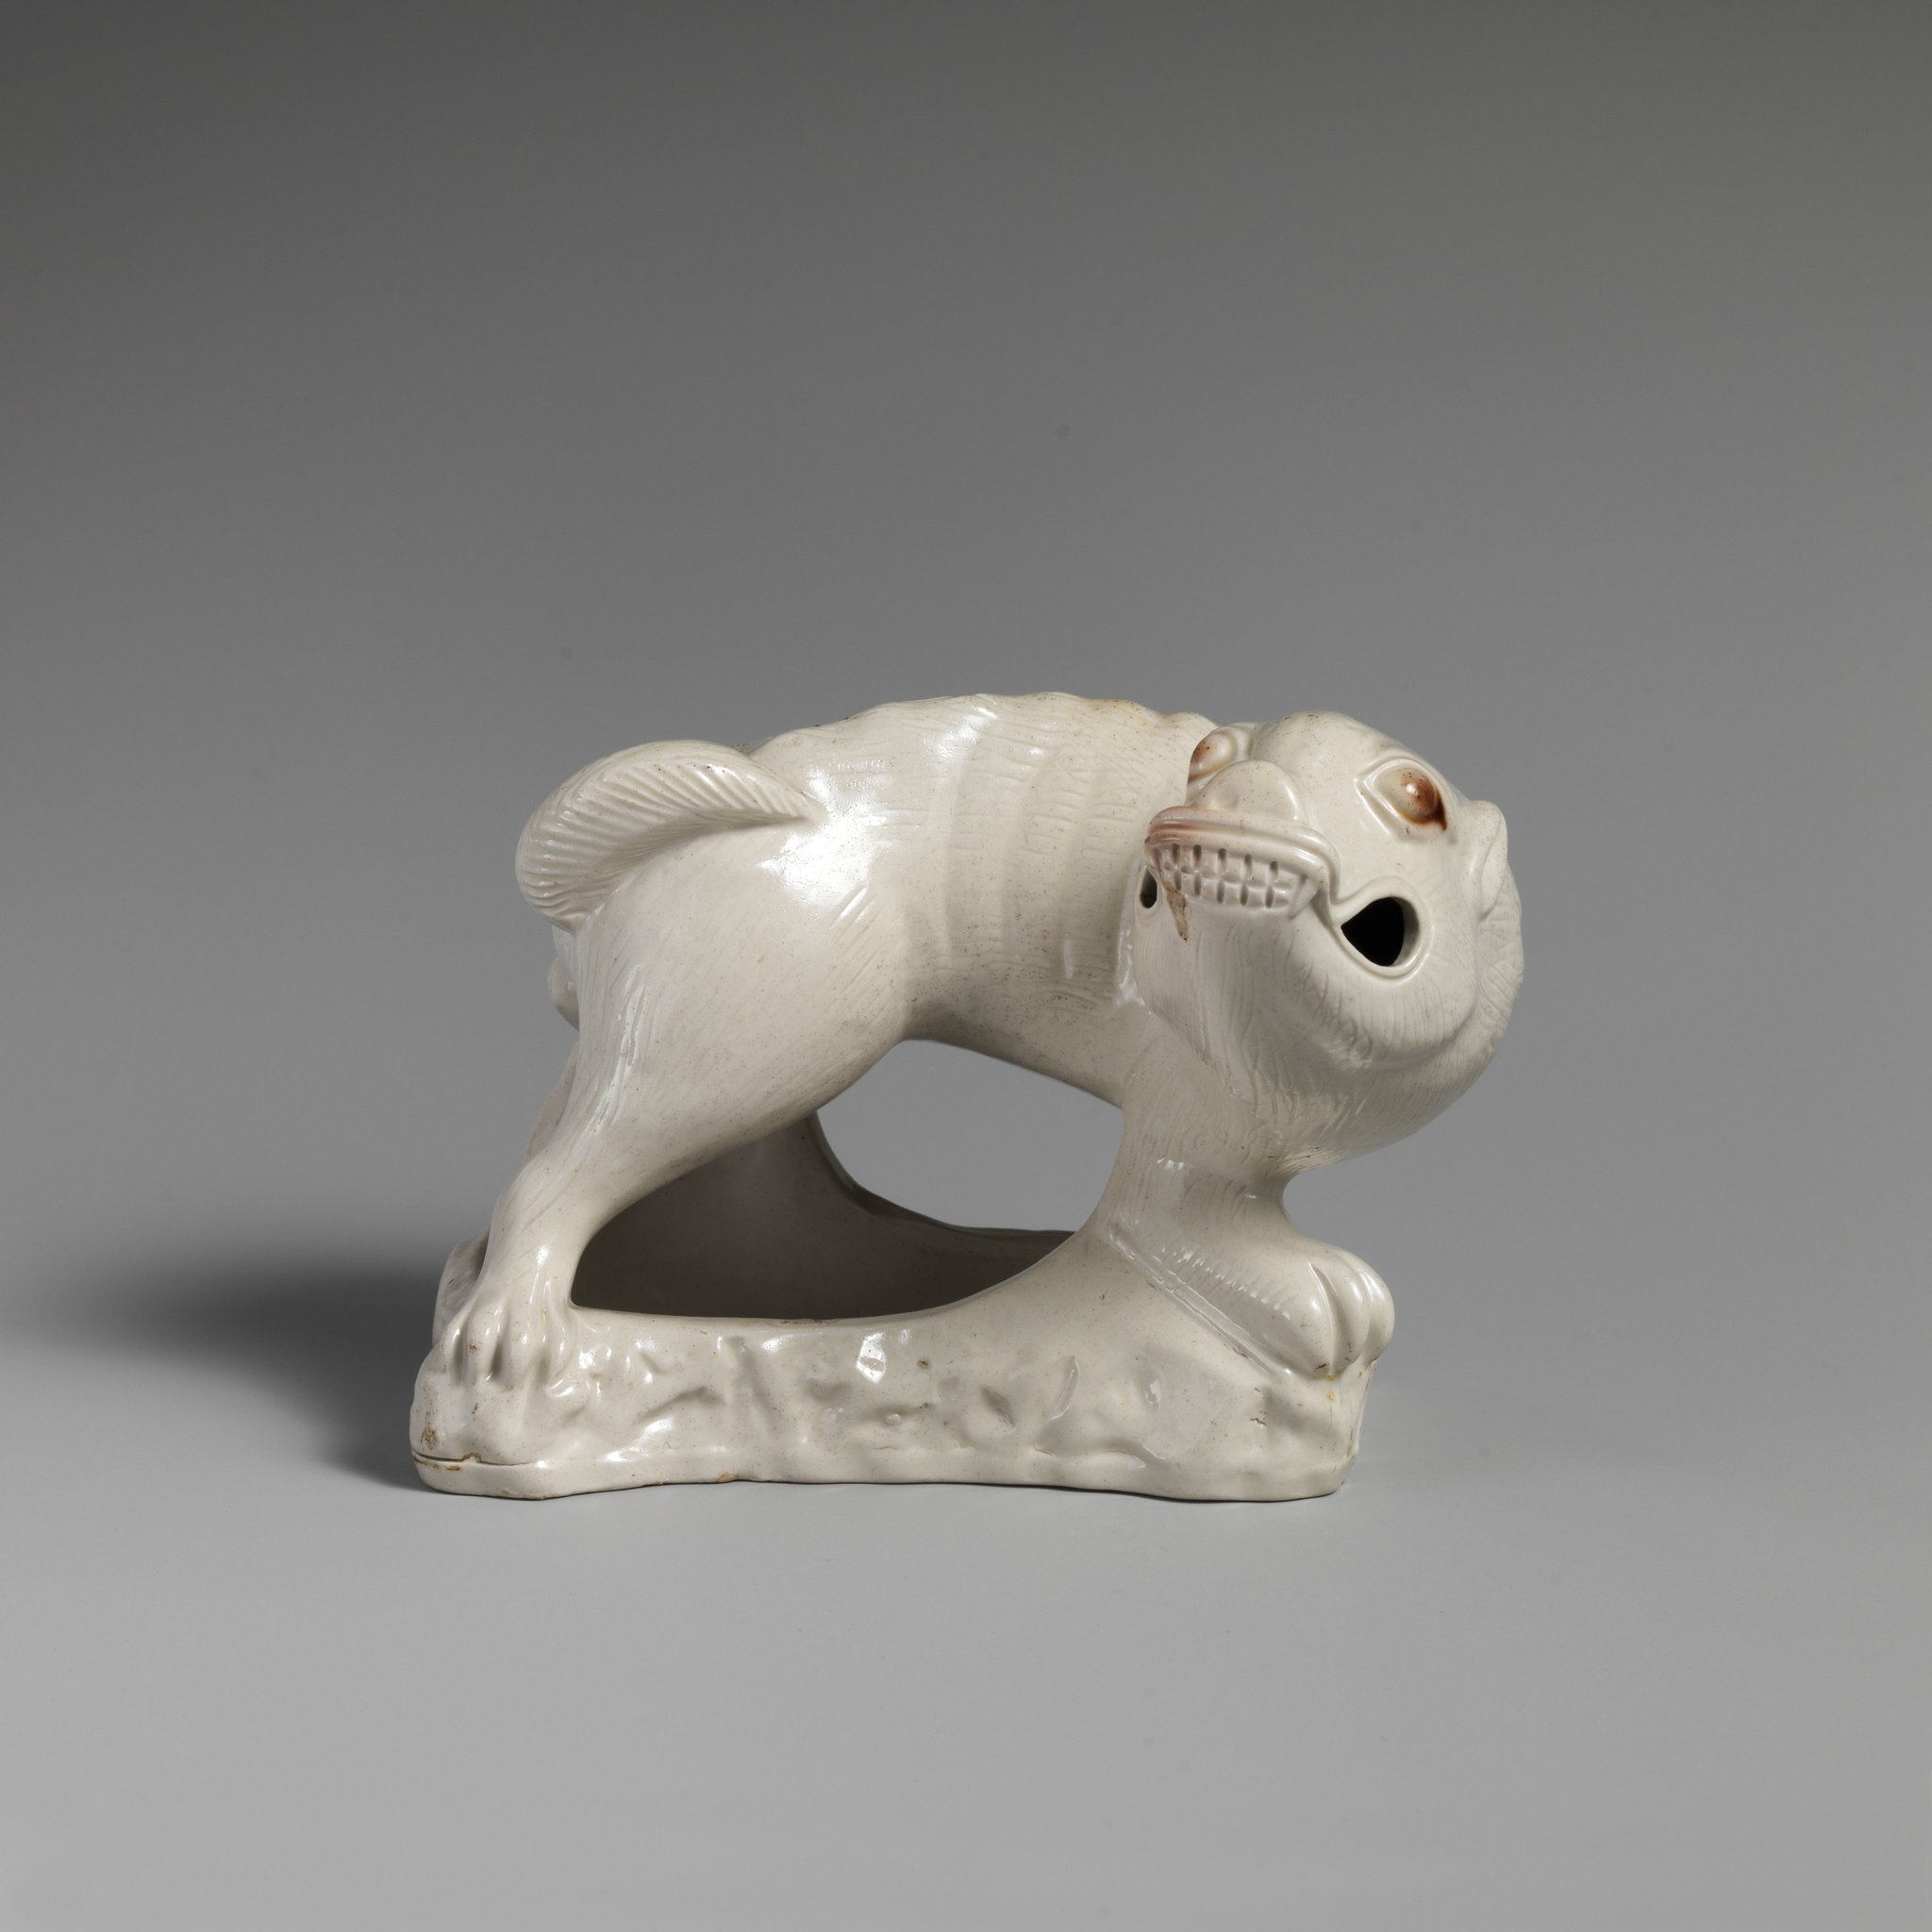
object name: figure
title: Bulldog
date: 1701-1800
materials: stoneware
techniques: salt glaze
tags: dogs